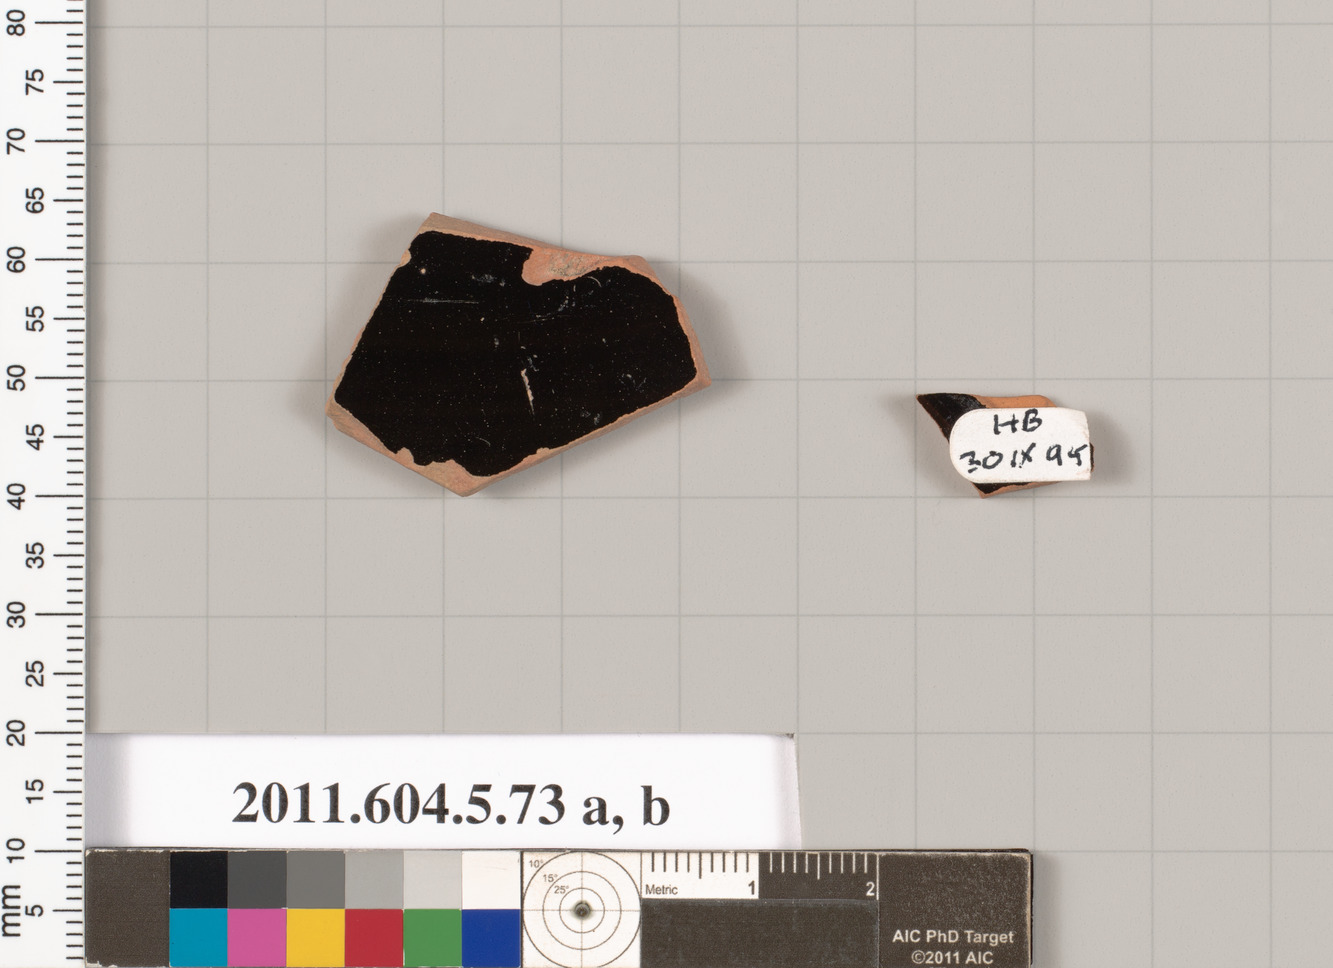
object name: kylix fragment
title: Terracotta fragments of kylikes (drinking cups)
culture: greek, attic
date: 500-451 BCE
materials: terracotta